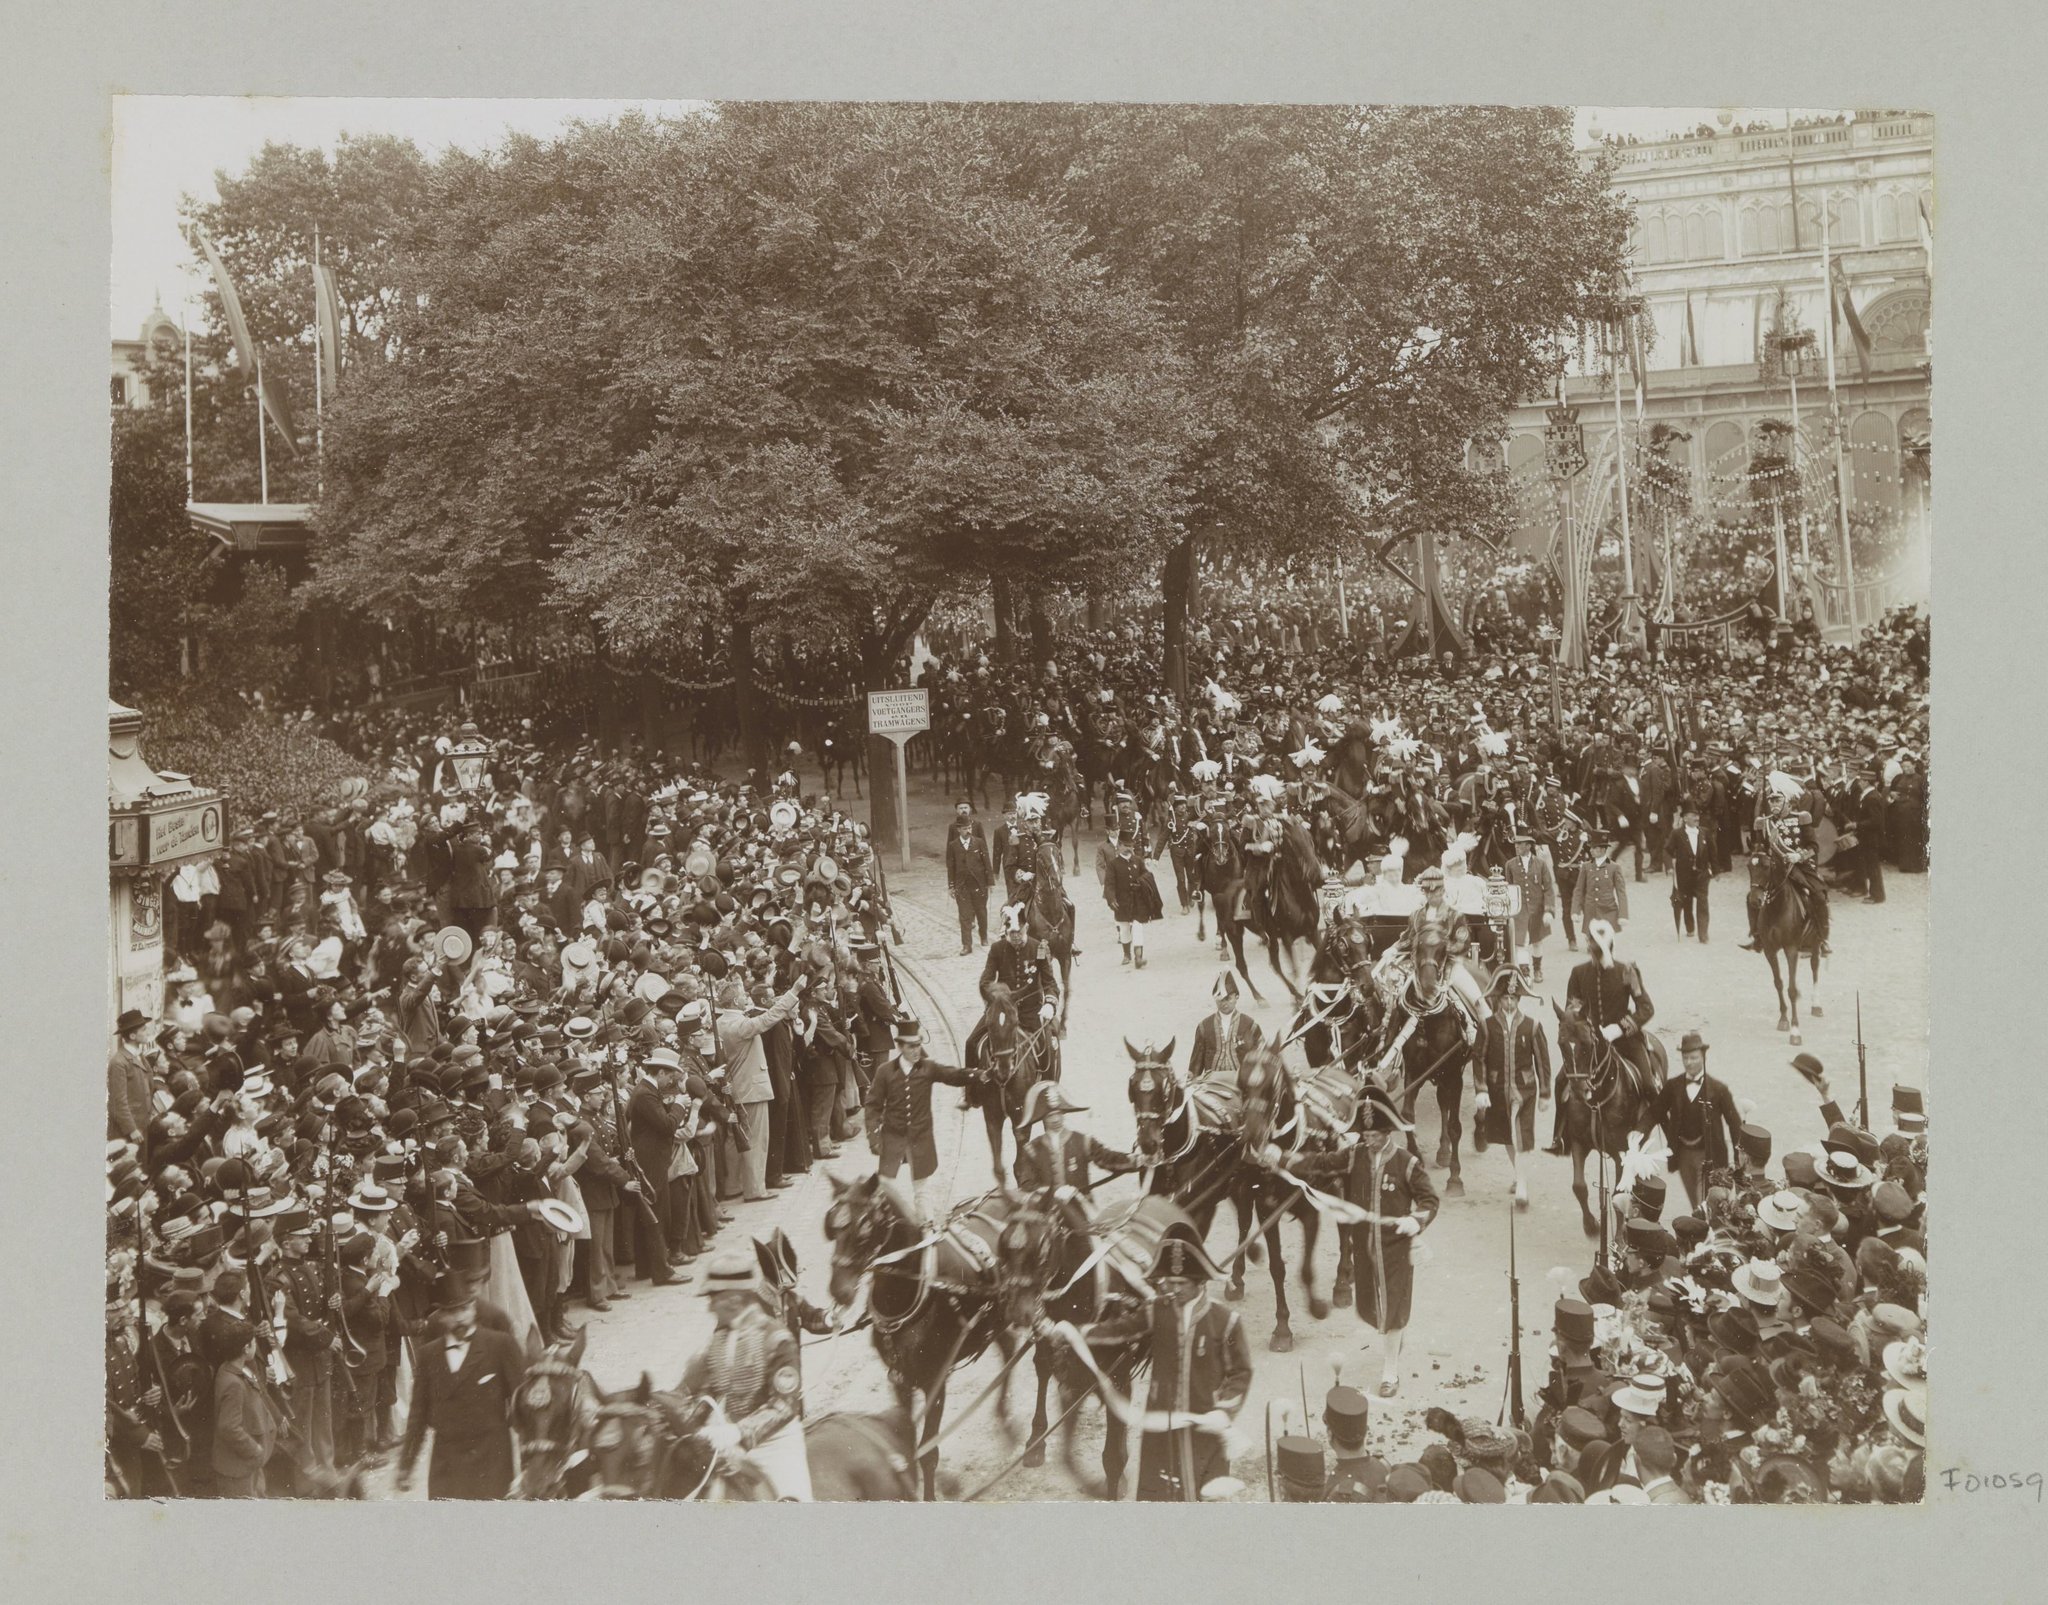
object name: photograph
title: Open rijtuig met koningin Wilhelmina en koningin-moeder Emma en escorte bij de inhuldiging op het Frederiksplein in Amsterdam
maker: barend groote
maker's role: fotograaf, fotohandel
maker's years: 1862-1946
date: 1809-1898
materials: photographic support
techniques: collodion silver print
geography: frederiksplein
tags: print maker, wilhelmina of the netherlands, the hague, emma (queen consort of the netherlands), riding a horse, ass, or mule; rider, horseman, ceremonial celebration of installation of a ruler, crowd, mob, public festivities on the occasion of royal events, installation of a ruler - bb - female ruler, four-wheeled, animal-drawn vehicle, e.g.: cab, carriage, coach, palace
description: Onderdeel van Fotoalbum met vijftien opnames van de inhuldiging van koningin Wilhelmina en de inhuldigingsfeesten.